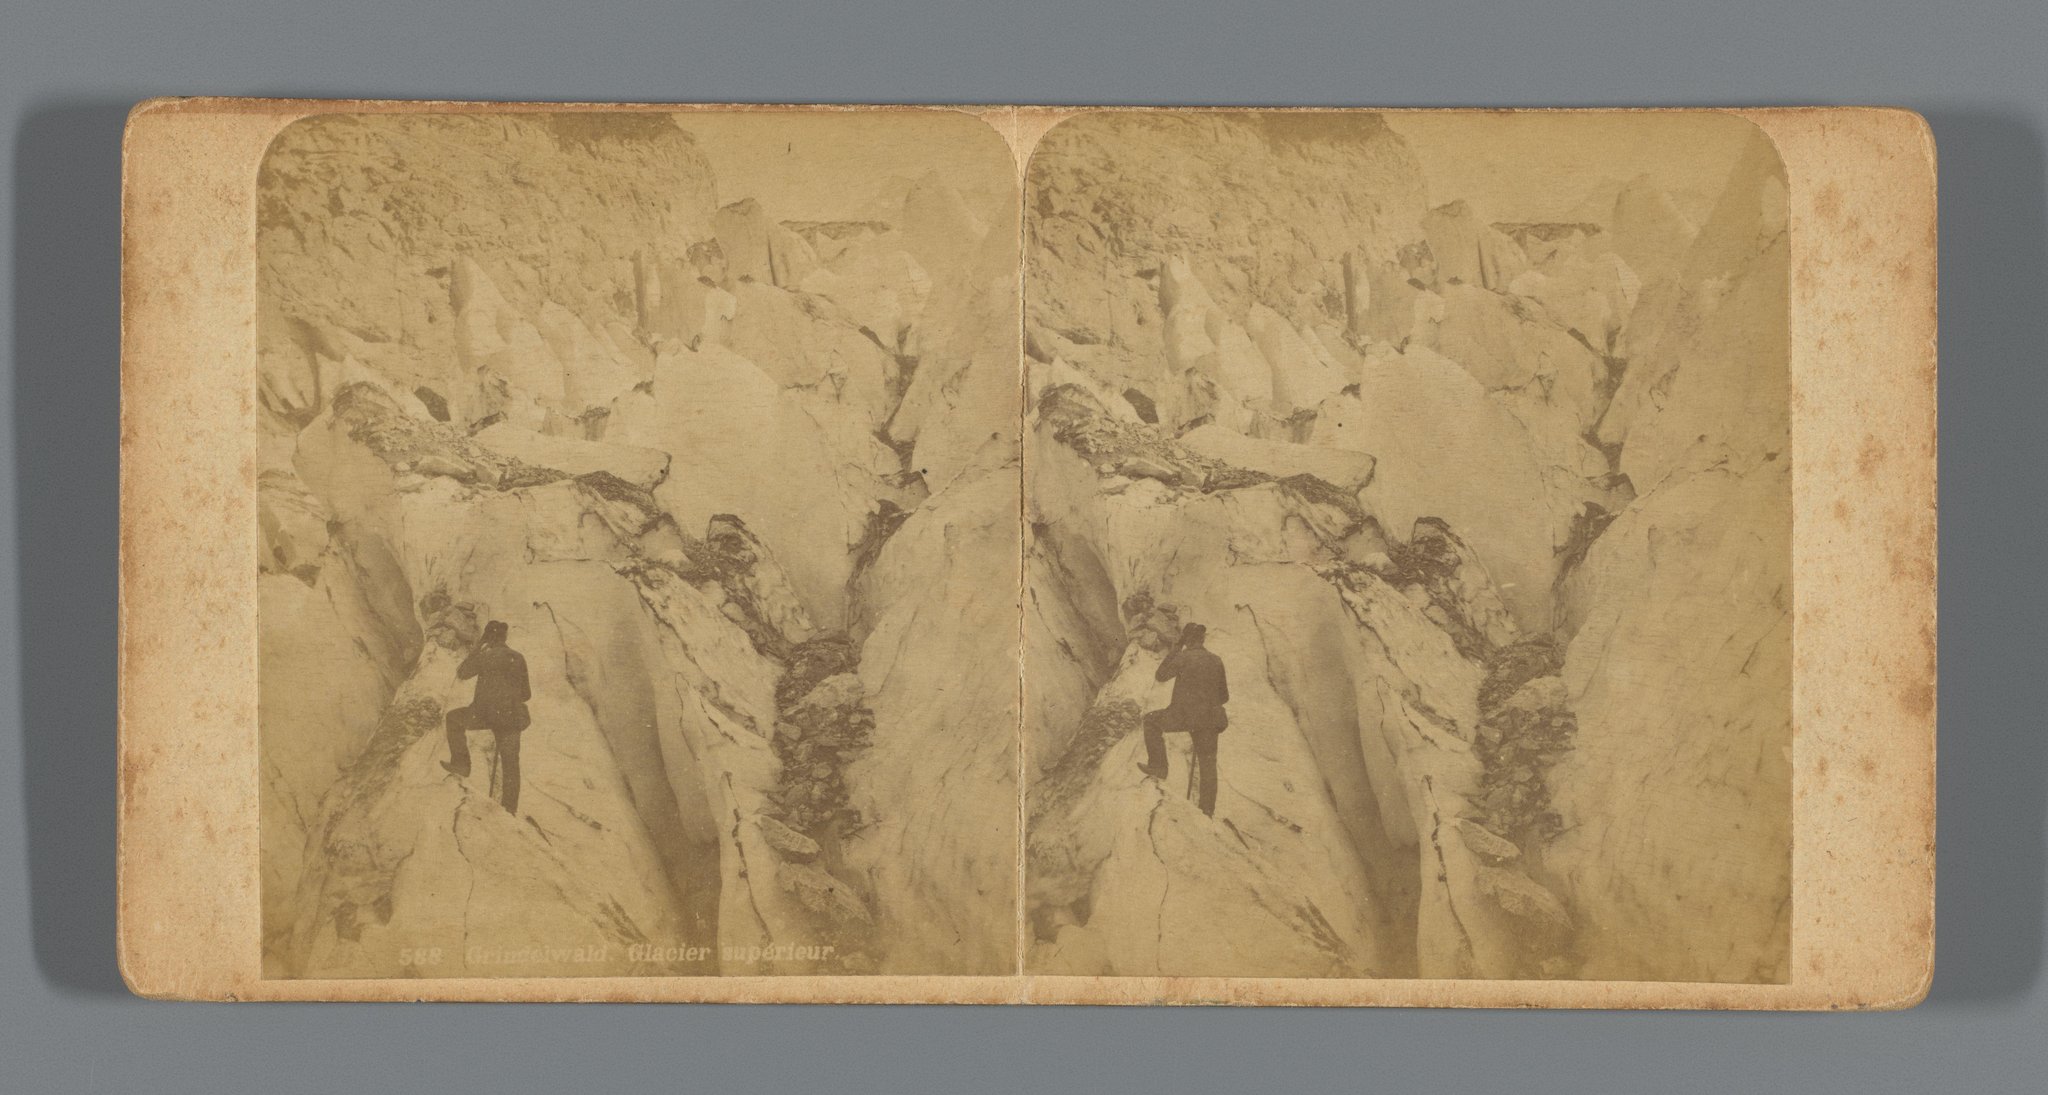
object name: stereograph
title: Aardrijkskundige Beeldengalerij, verzameld door M.J. Broekhuijsen, Hoofd eener school te Amsterdam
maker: martien johan broekhuijsen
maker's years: 1871-1956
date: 1905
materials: photographic support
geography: amsterdam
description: Onderdeel van een groep van 52 stereofoto's gebruikt in het lager onderwijs als aanvulling op schoolplaten. De gehele reeks bestond uit 274 nummers in 10 categorieën (A t/m K).